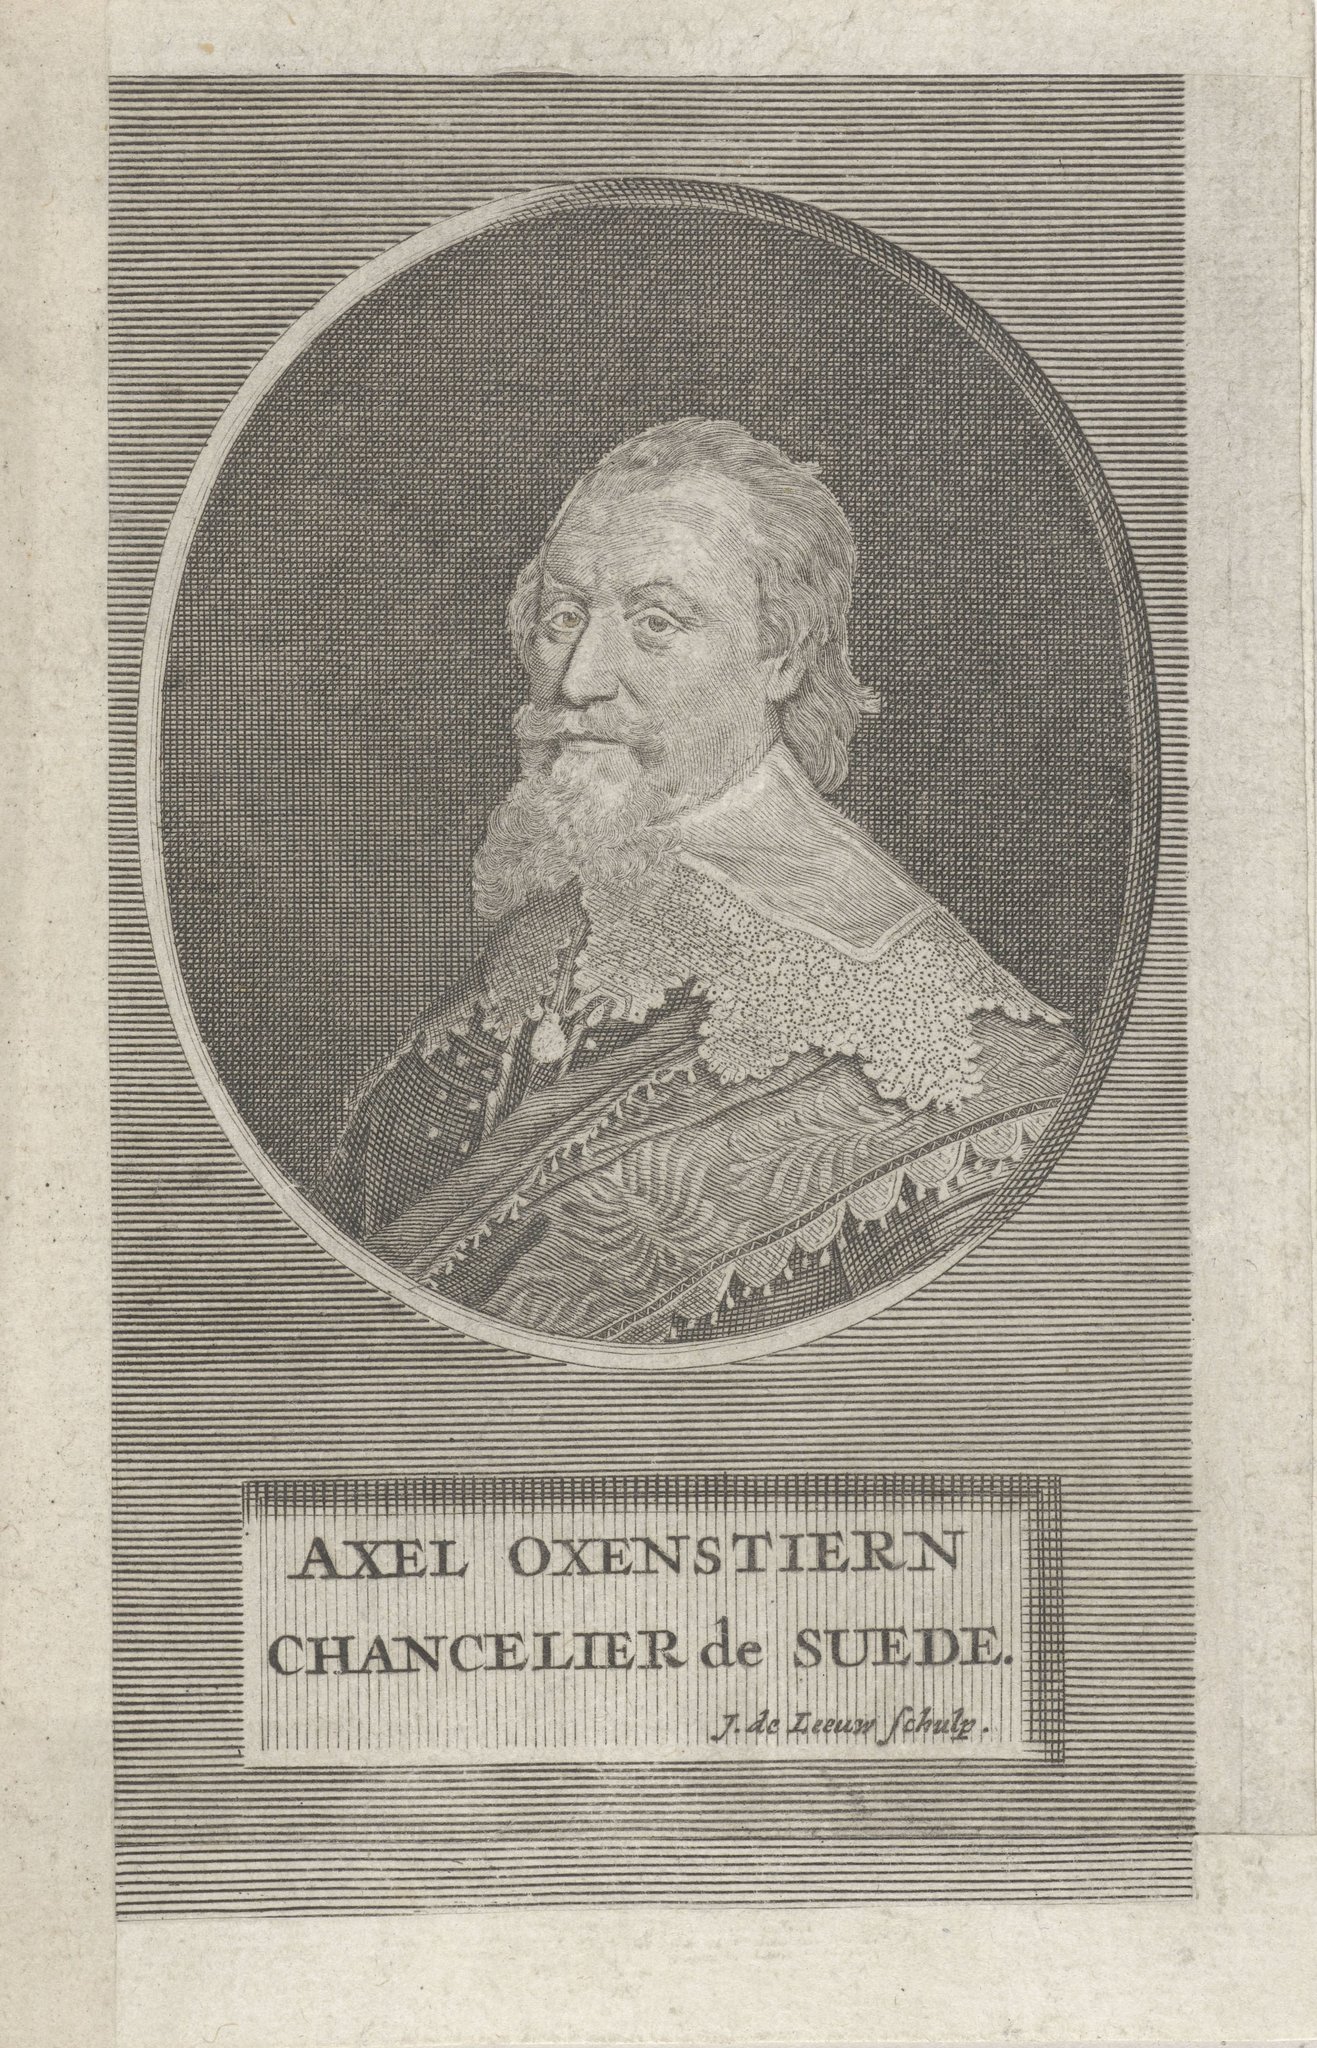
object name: print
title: Portret van Axel Oxenstierna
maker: jan de leeuw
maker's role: print maker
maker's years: 1660-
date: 1704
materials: paper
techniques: engraving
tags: stockholm, staatsman, axel oxenstierna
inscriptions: collector's mark: Lugt 2228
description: Portretbuste in ovaal naar links van Axel Oxenstierna, Zweeds staatsman, blootshoofds. Onder het portret staat op een plaquette de naam van de geportretteerde.